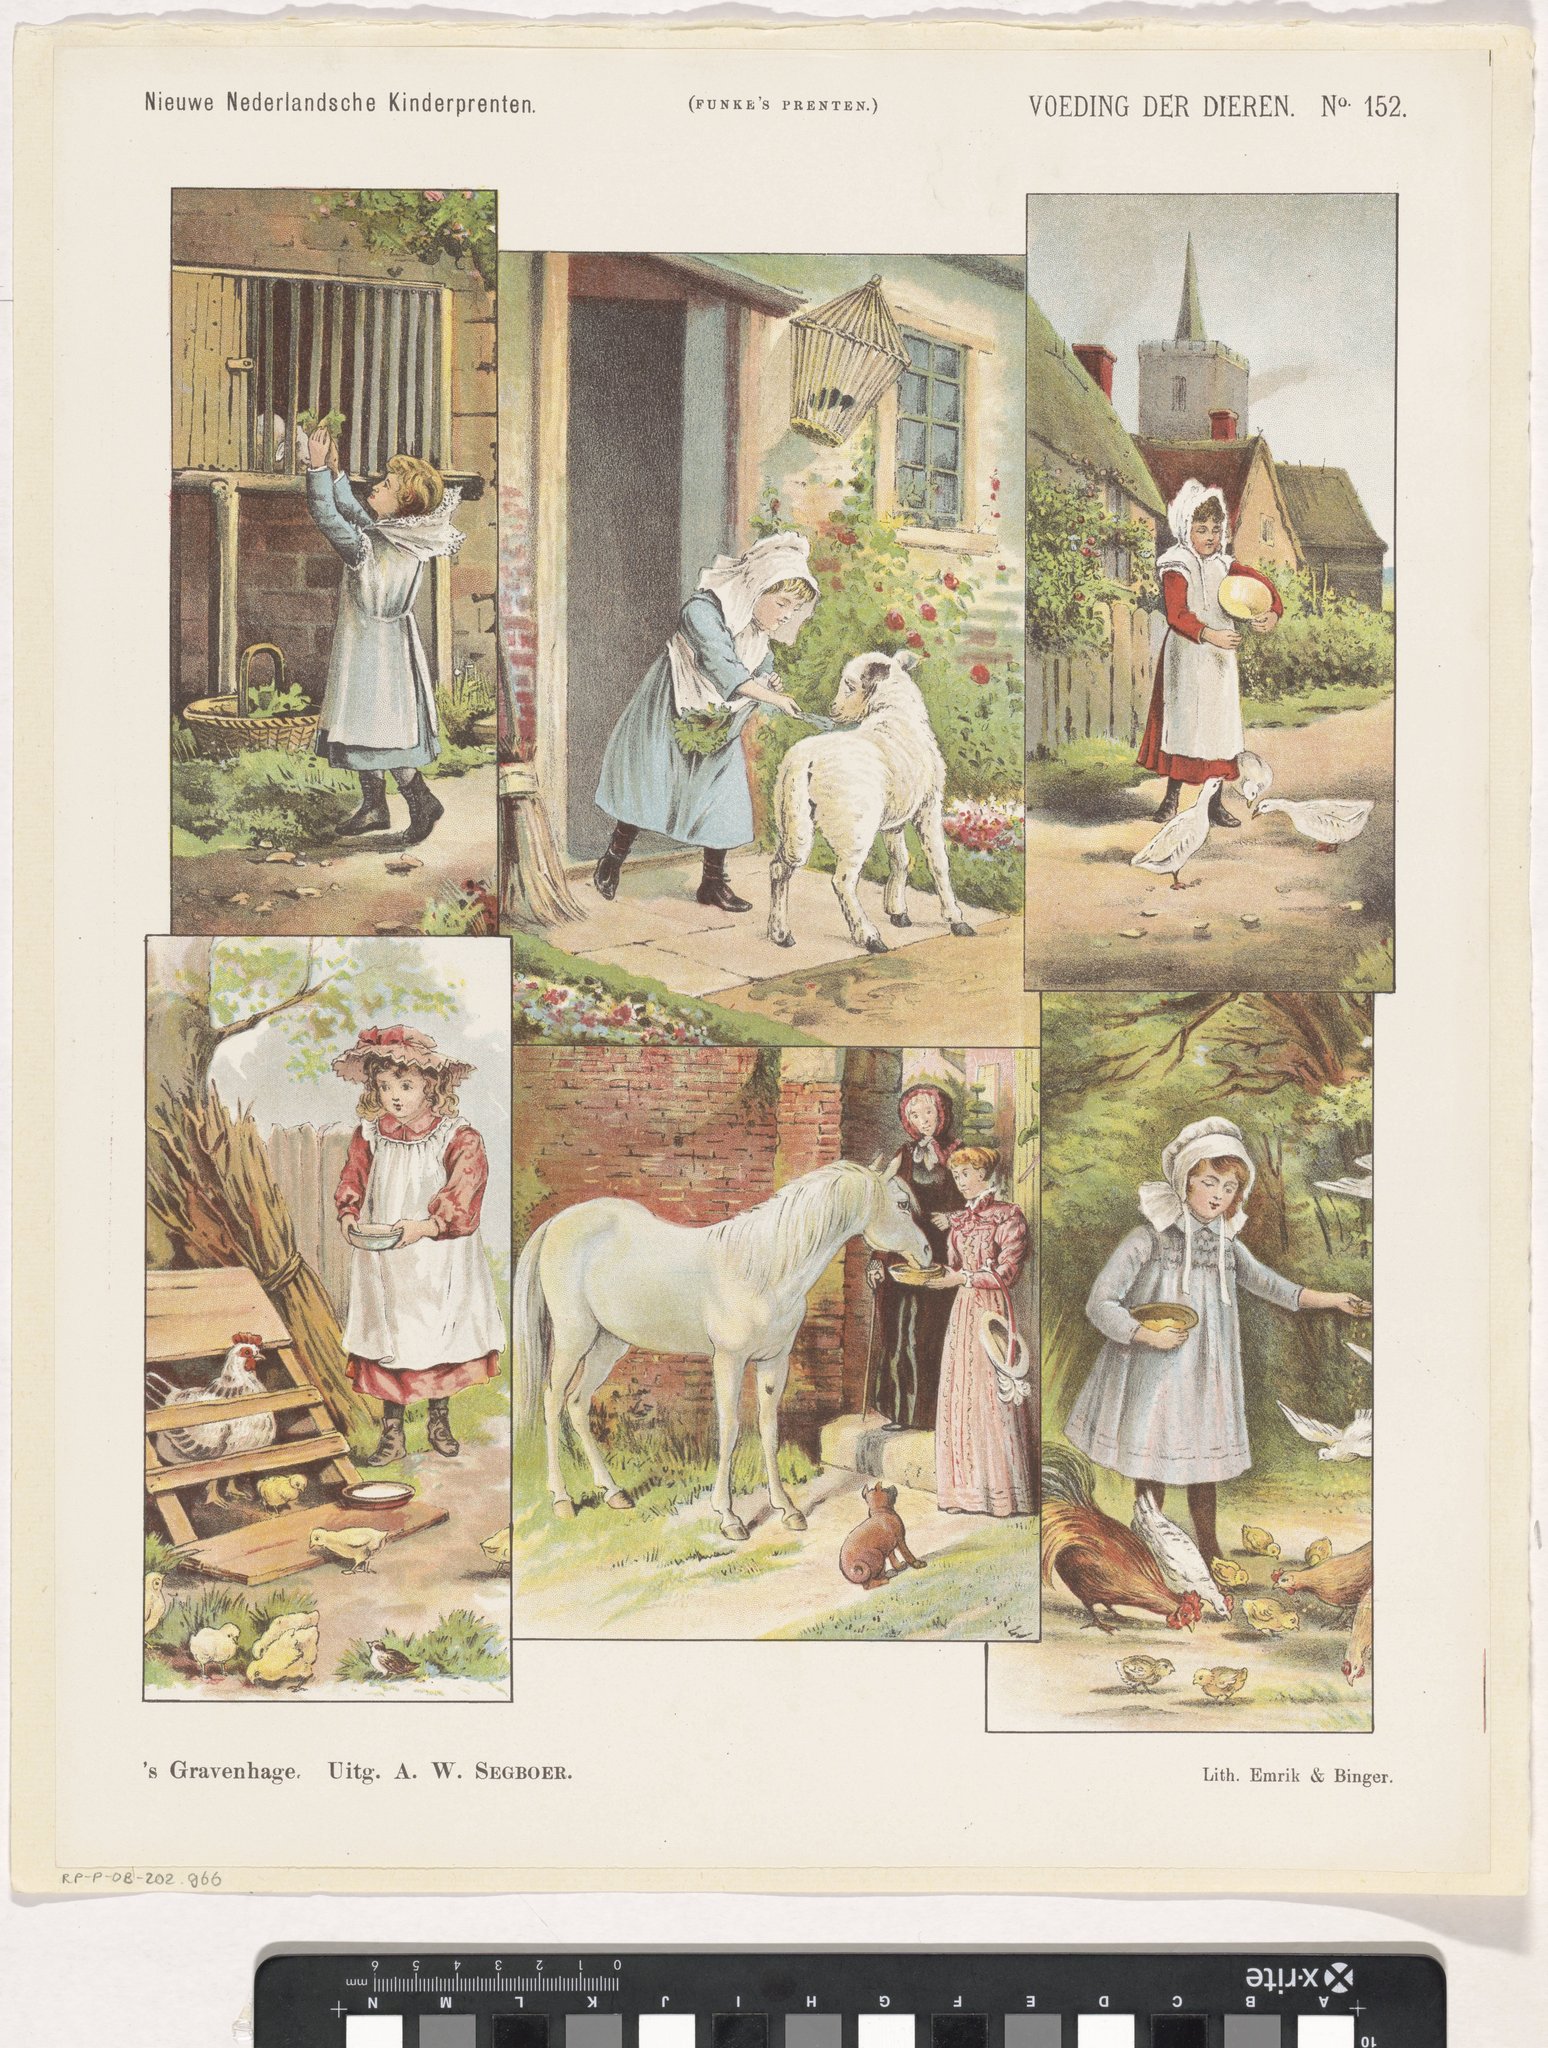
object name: print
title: Voeding der dieren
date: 1903-1919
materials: paper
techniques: lithograph, letterpress printing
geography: the hague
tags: fowl (cock, hen, chicken, etc.) (+ feeding animal), child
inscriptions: collector's mark: Lugt 2760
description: Blad met 6 voorstellingen van kinderen die dieren voeren. Genummerd rechtsboven: No. 152.